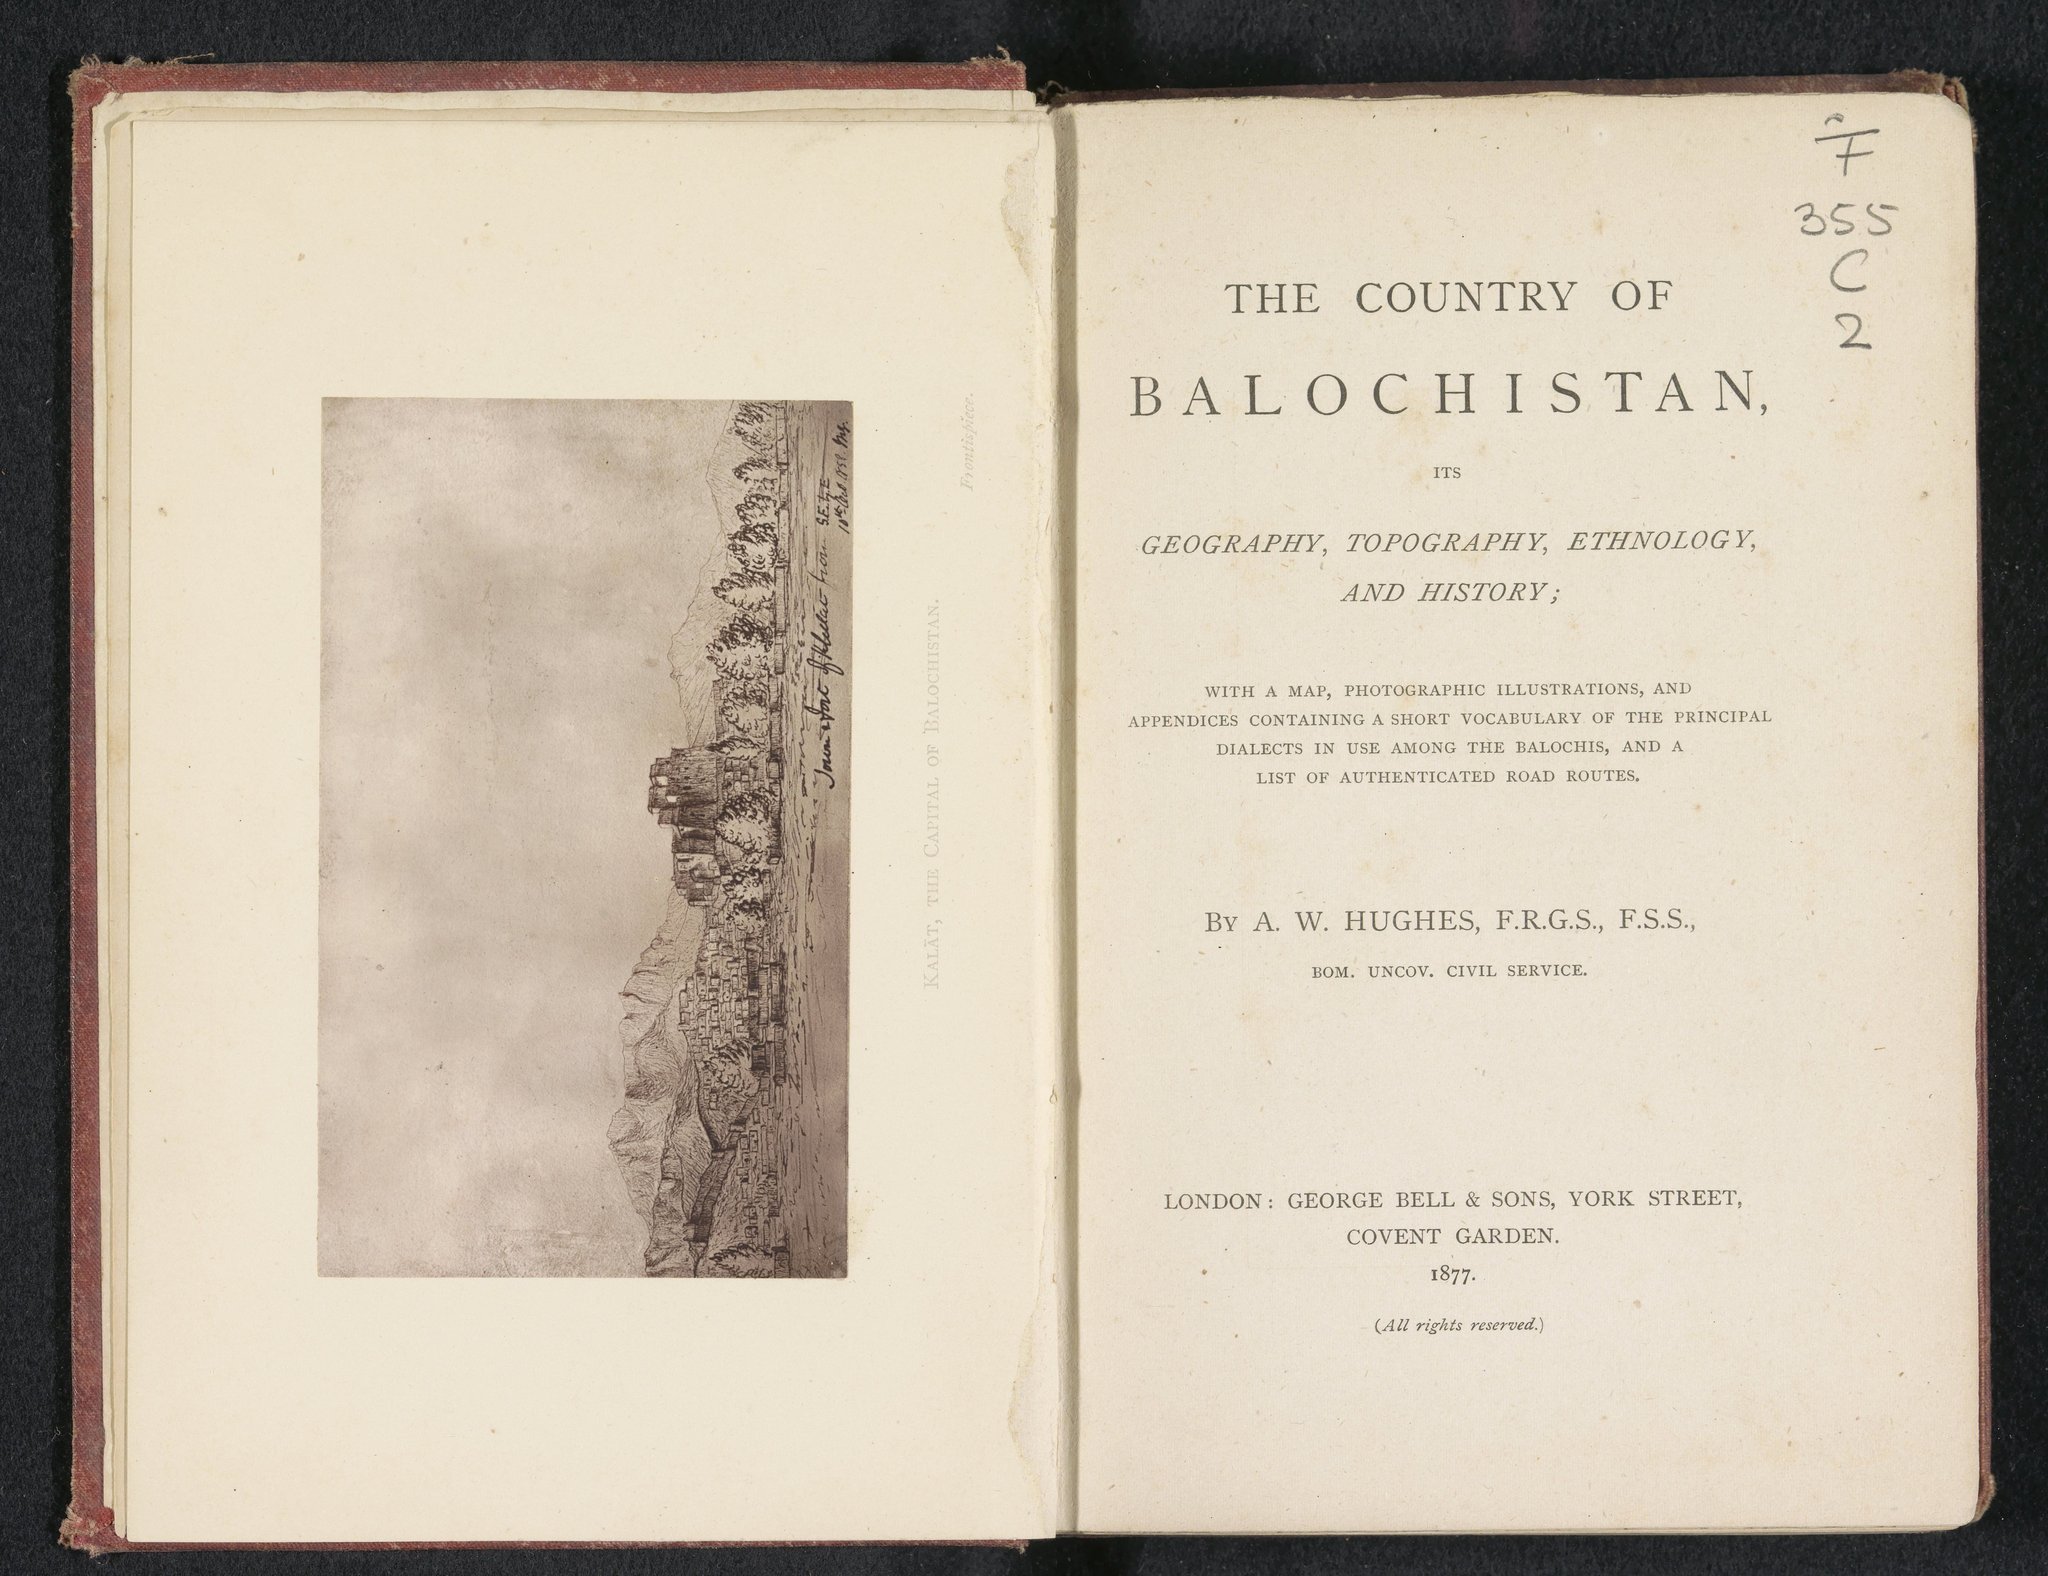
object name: reproduction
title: Kalāt, the capital of Balochistan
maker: Anonymous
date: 1866-1876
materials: paper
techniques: woodburytype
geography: kalat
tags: city-view in general; 'veduta'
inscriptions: inscription: ‘Frontispiece.’, inscription: ‘Town & Fort of Khalat from S.F.L.E. 10th Oct 1858 MS.’